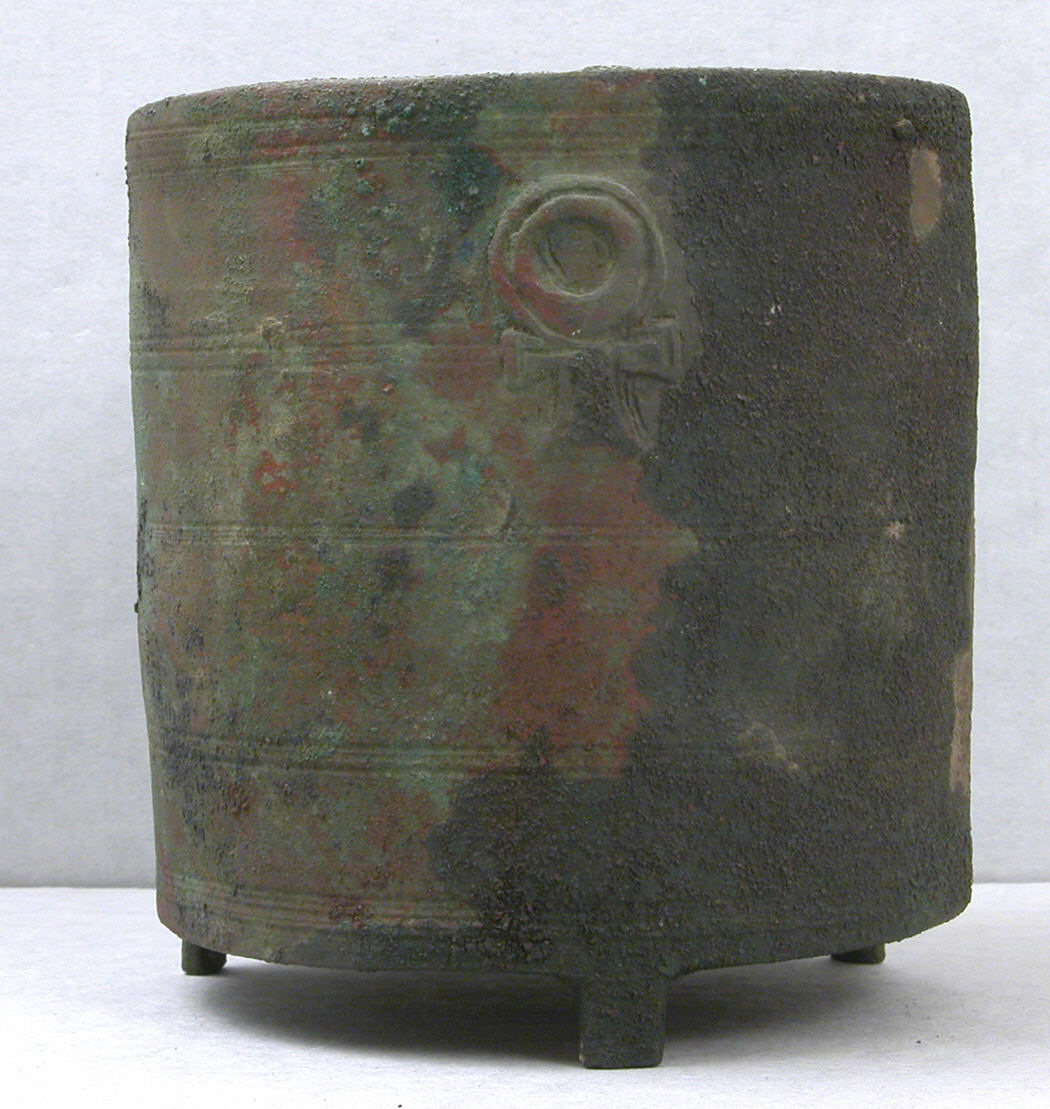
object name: bowl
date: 201-700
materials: bronze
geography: egypt